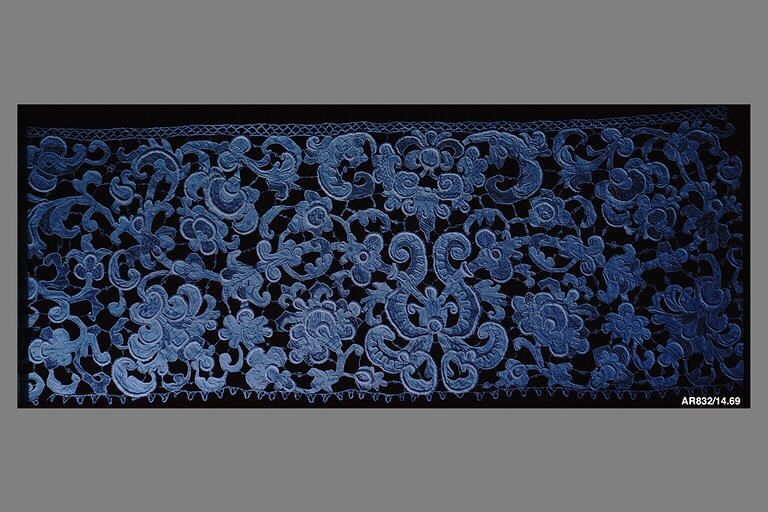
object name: flounce fragment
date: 1667-1700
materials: lace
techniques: gros point, lace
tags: flowers